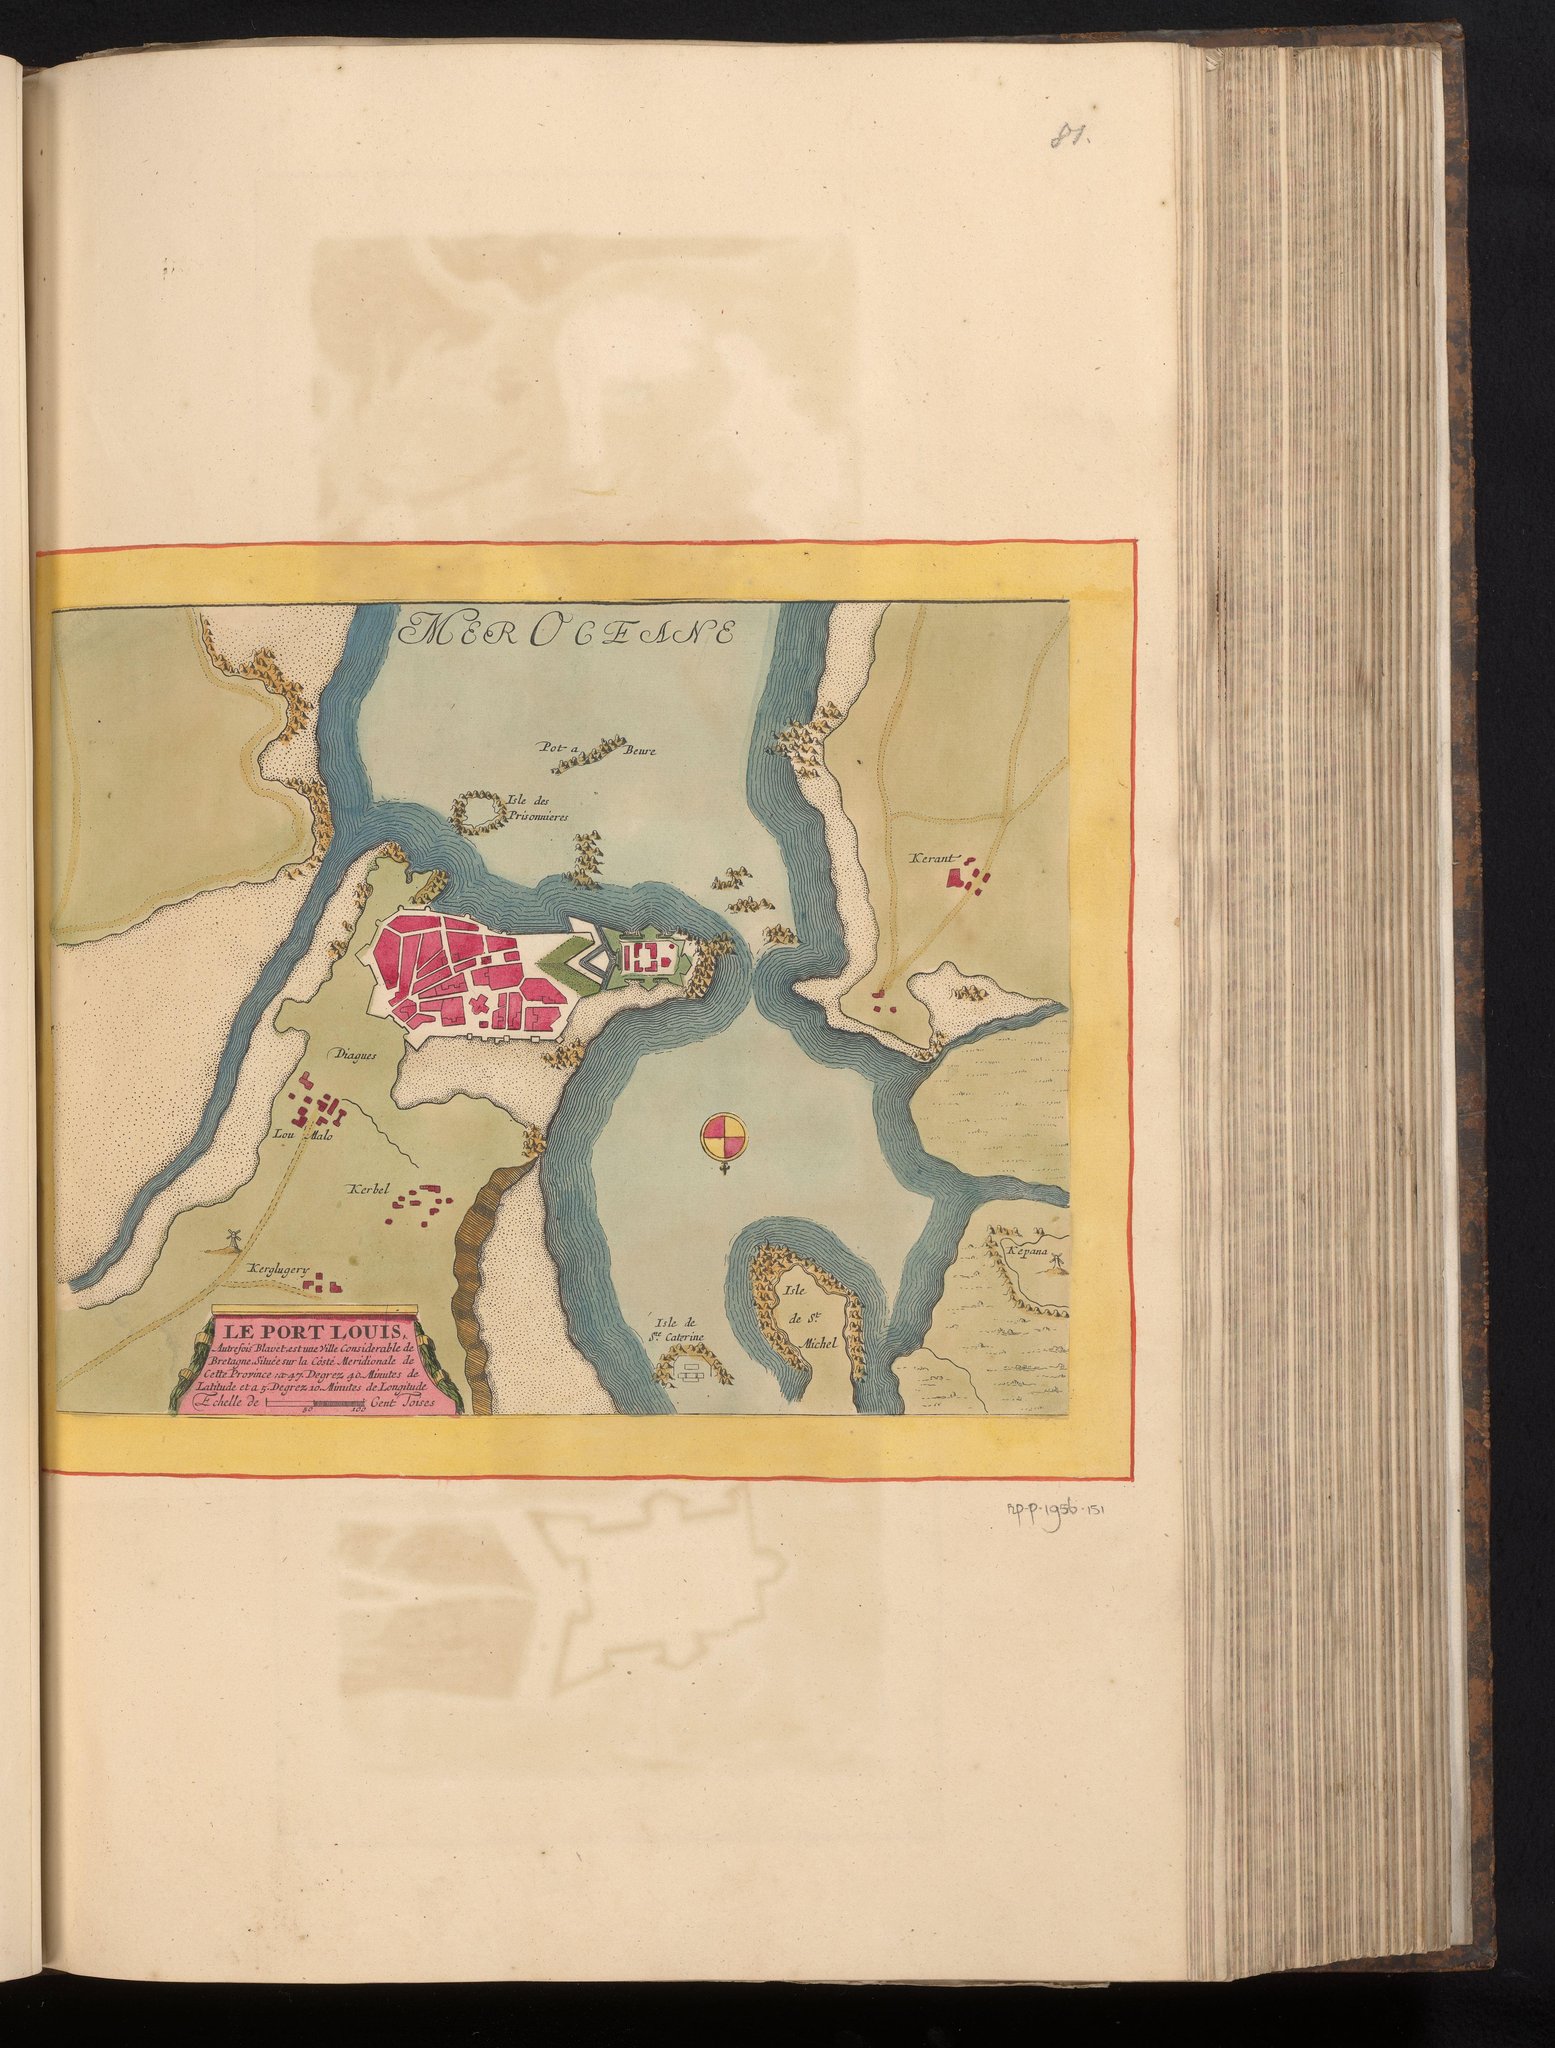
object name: map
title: Kaart van Port-Louis en omgeving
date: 1690-1700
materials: paper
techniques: engraving, etching, hand coloring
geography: the hague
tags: maps of separate countries or regions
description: Kaart gebruikt in: Fer, Nicolas de. Les forces de l'Europe. 8 dln. Parijs: Nicolas de Fer, 1690-1695. Mortier, Pieter. Les forces de l'Europe. 10 dln. Amsterdam: Pieter Mortier, ca. 1700.